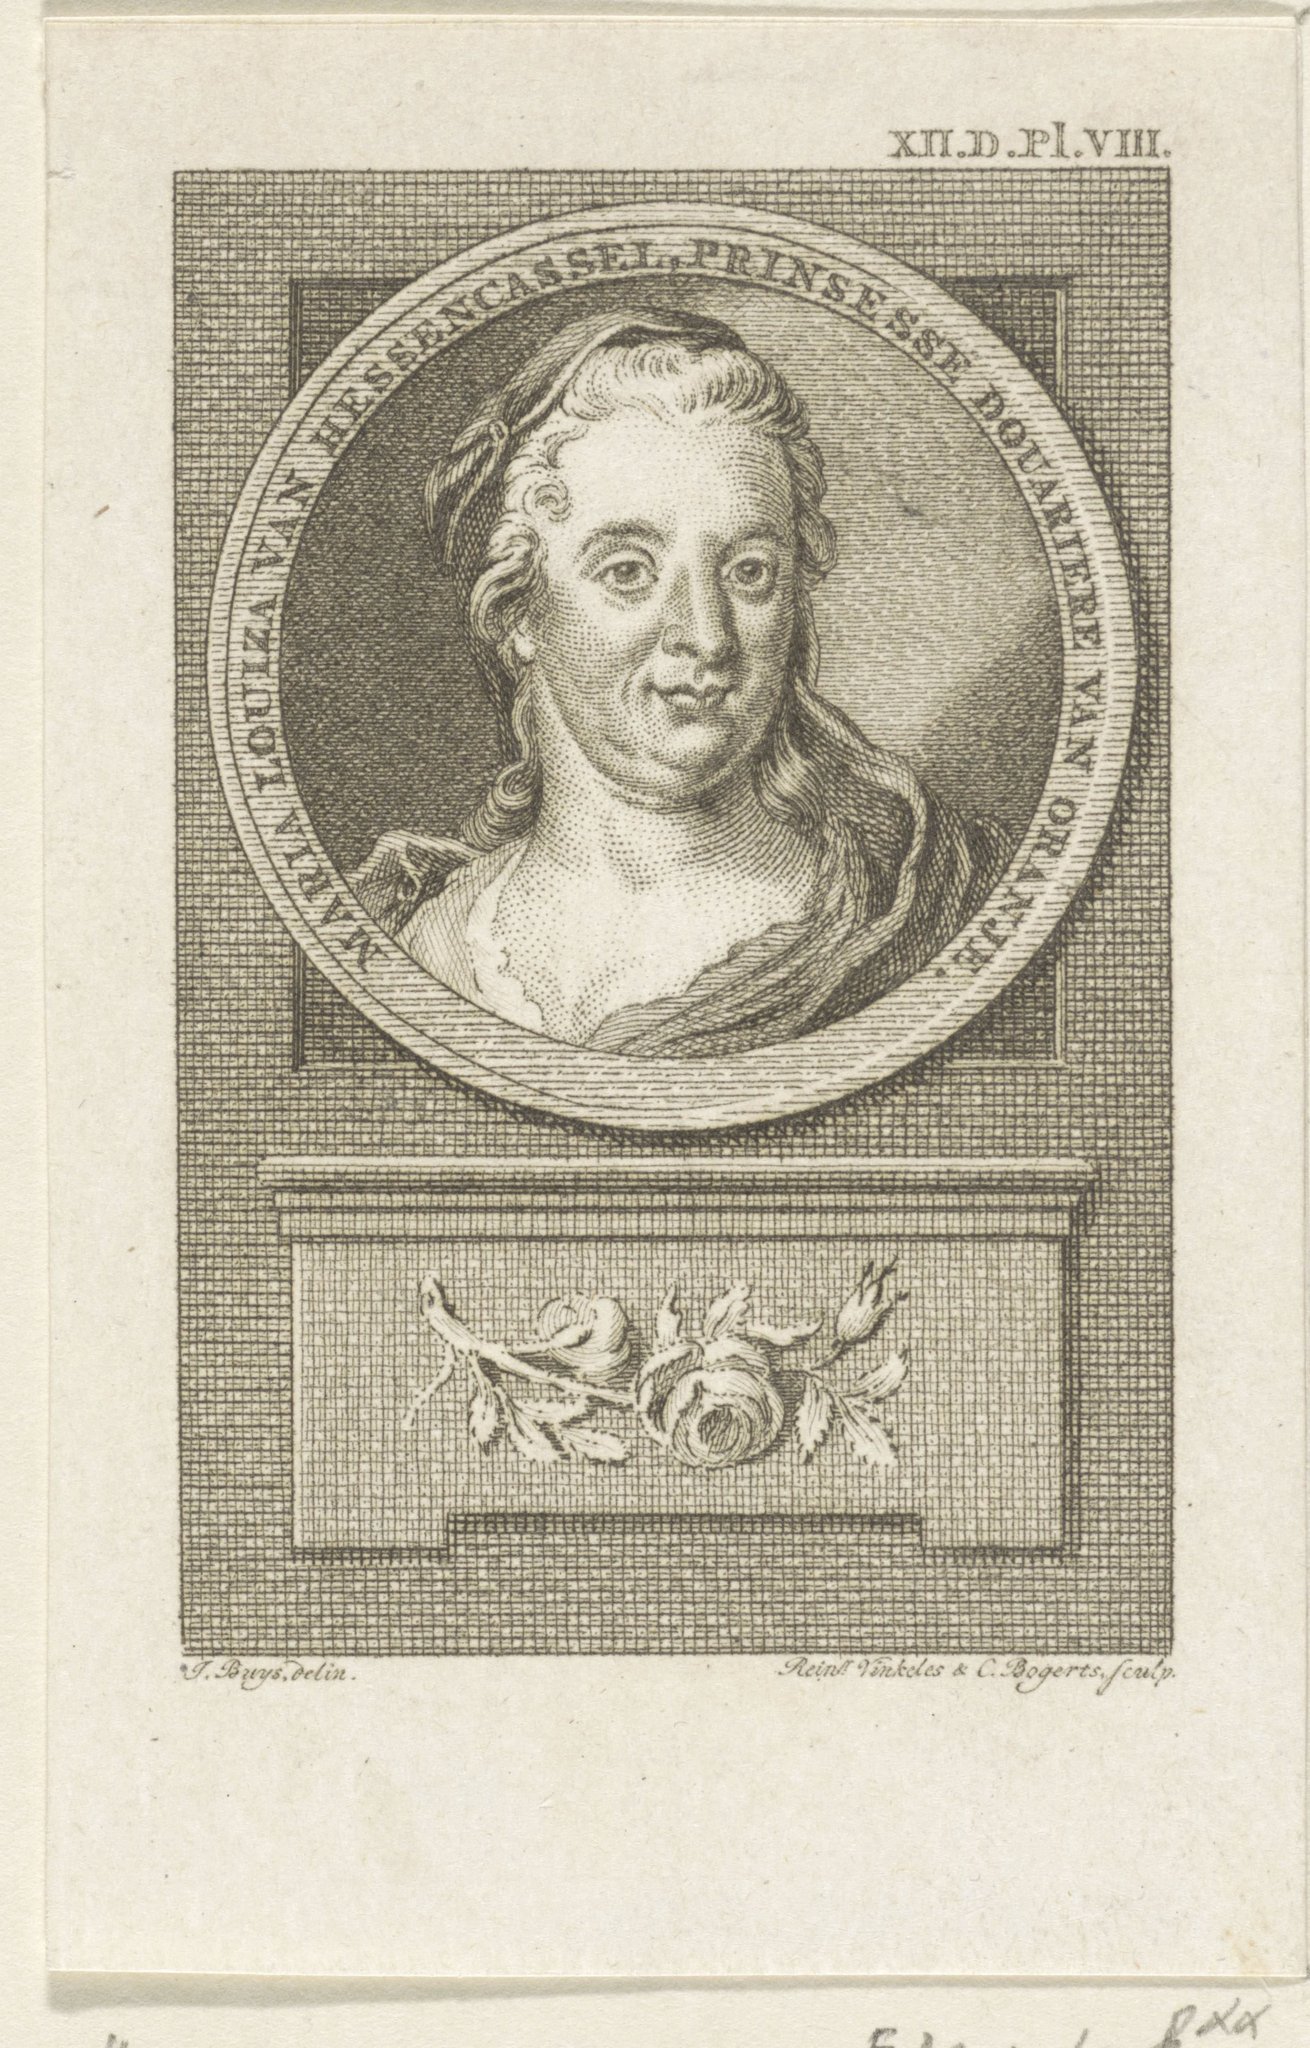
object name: print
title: Portret van Maria Louisa van Hessen-Kassel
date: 1771-1816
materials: paper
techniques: engraving, etching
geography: amsterdam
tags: kassel, leeuwarden, maria louisa van hessen-kassel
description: Portret van Maria Louisa in een cirkel met randschrift. Op een voetstuk een roos. Rechtsboven 'XXII .D .Pl .VIII .'.